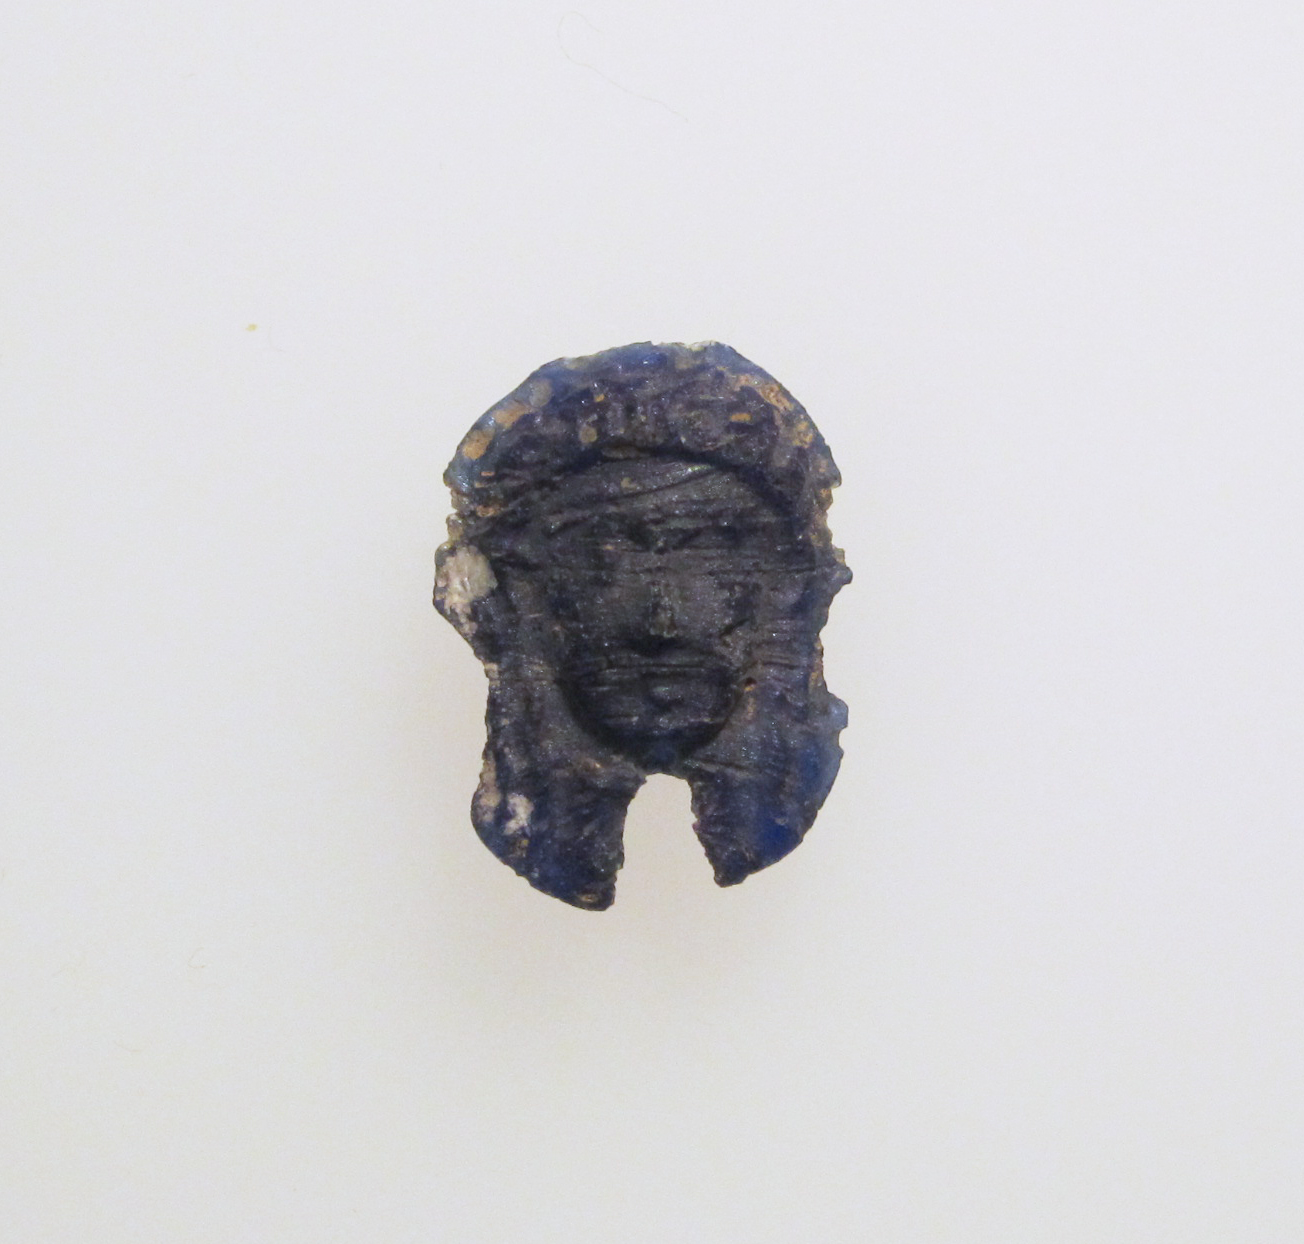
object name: pendant with female mask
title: Glass double-headed pendant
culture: punic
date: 334-201 BCE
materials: glass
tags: heads